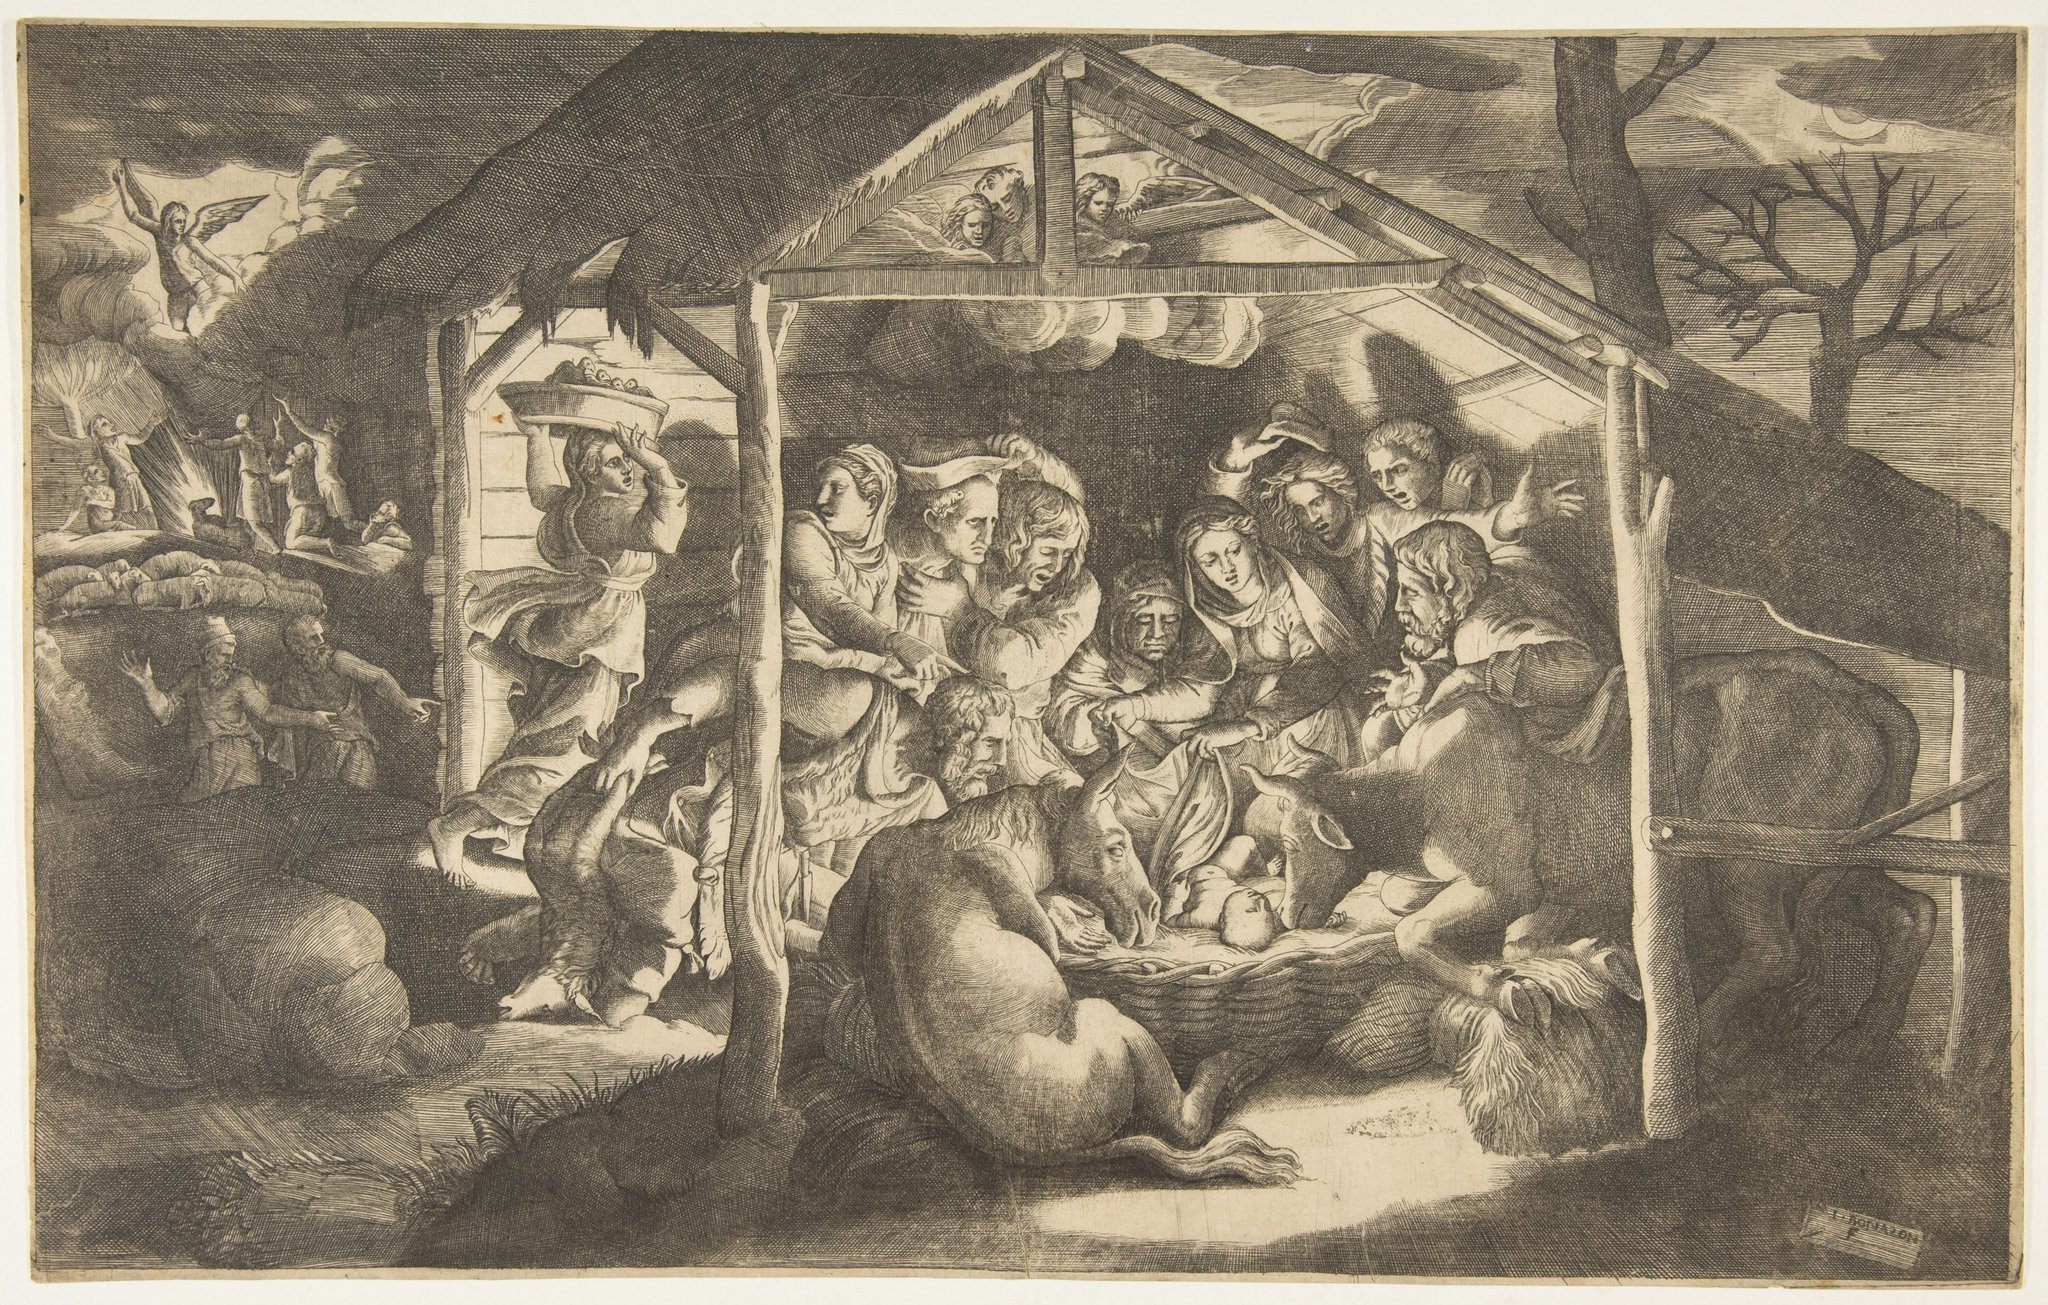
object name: print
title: The adoration of the shepherds, various figures surrounding the Christ Child in the centre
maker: giulio bonasone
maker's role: artist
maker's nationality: italian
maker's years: 1510-1576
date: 1531-1576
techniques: engraving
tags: horses,christ,adoration of the shepherds,shepherds